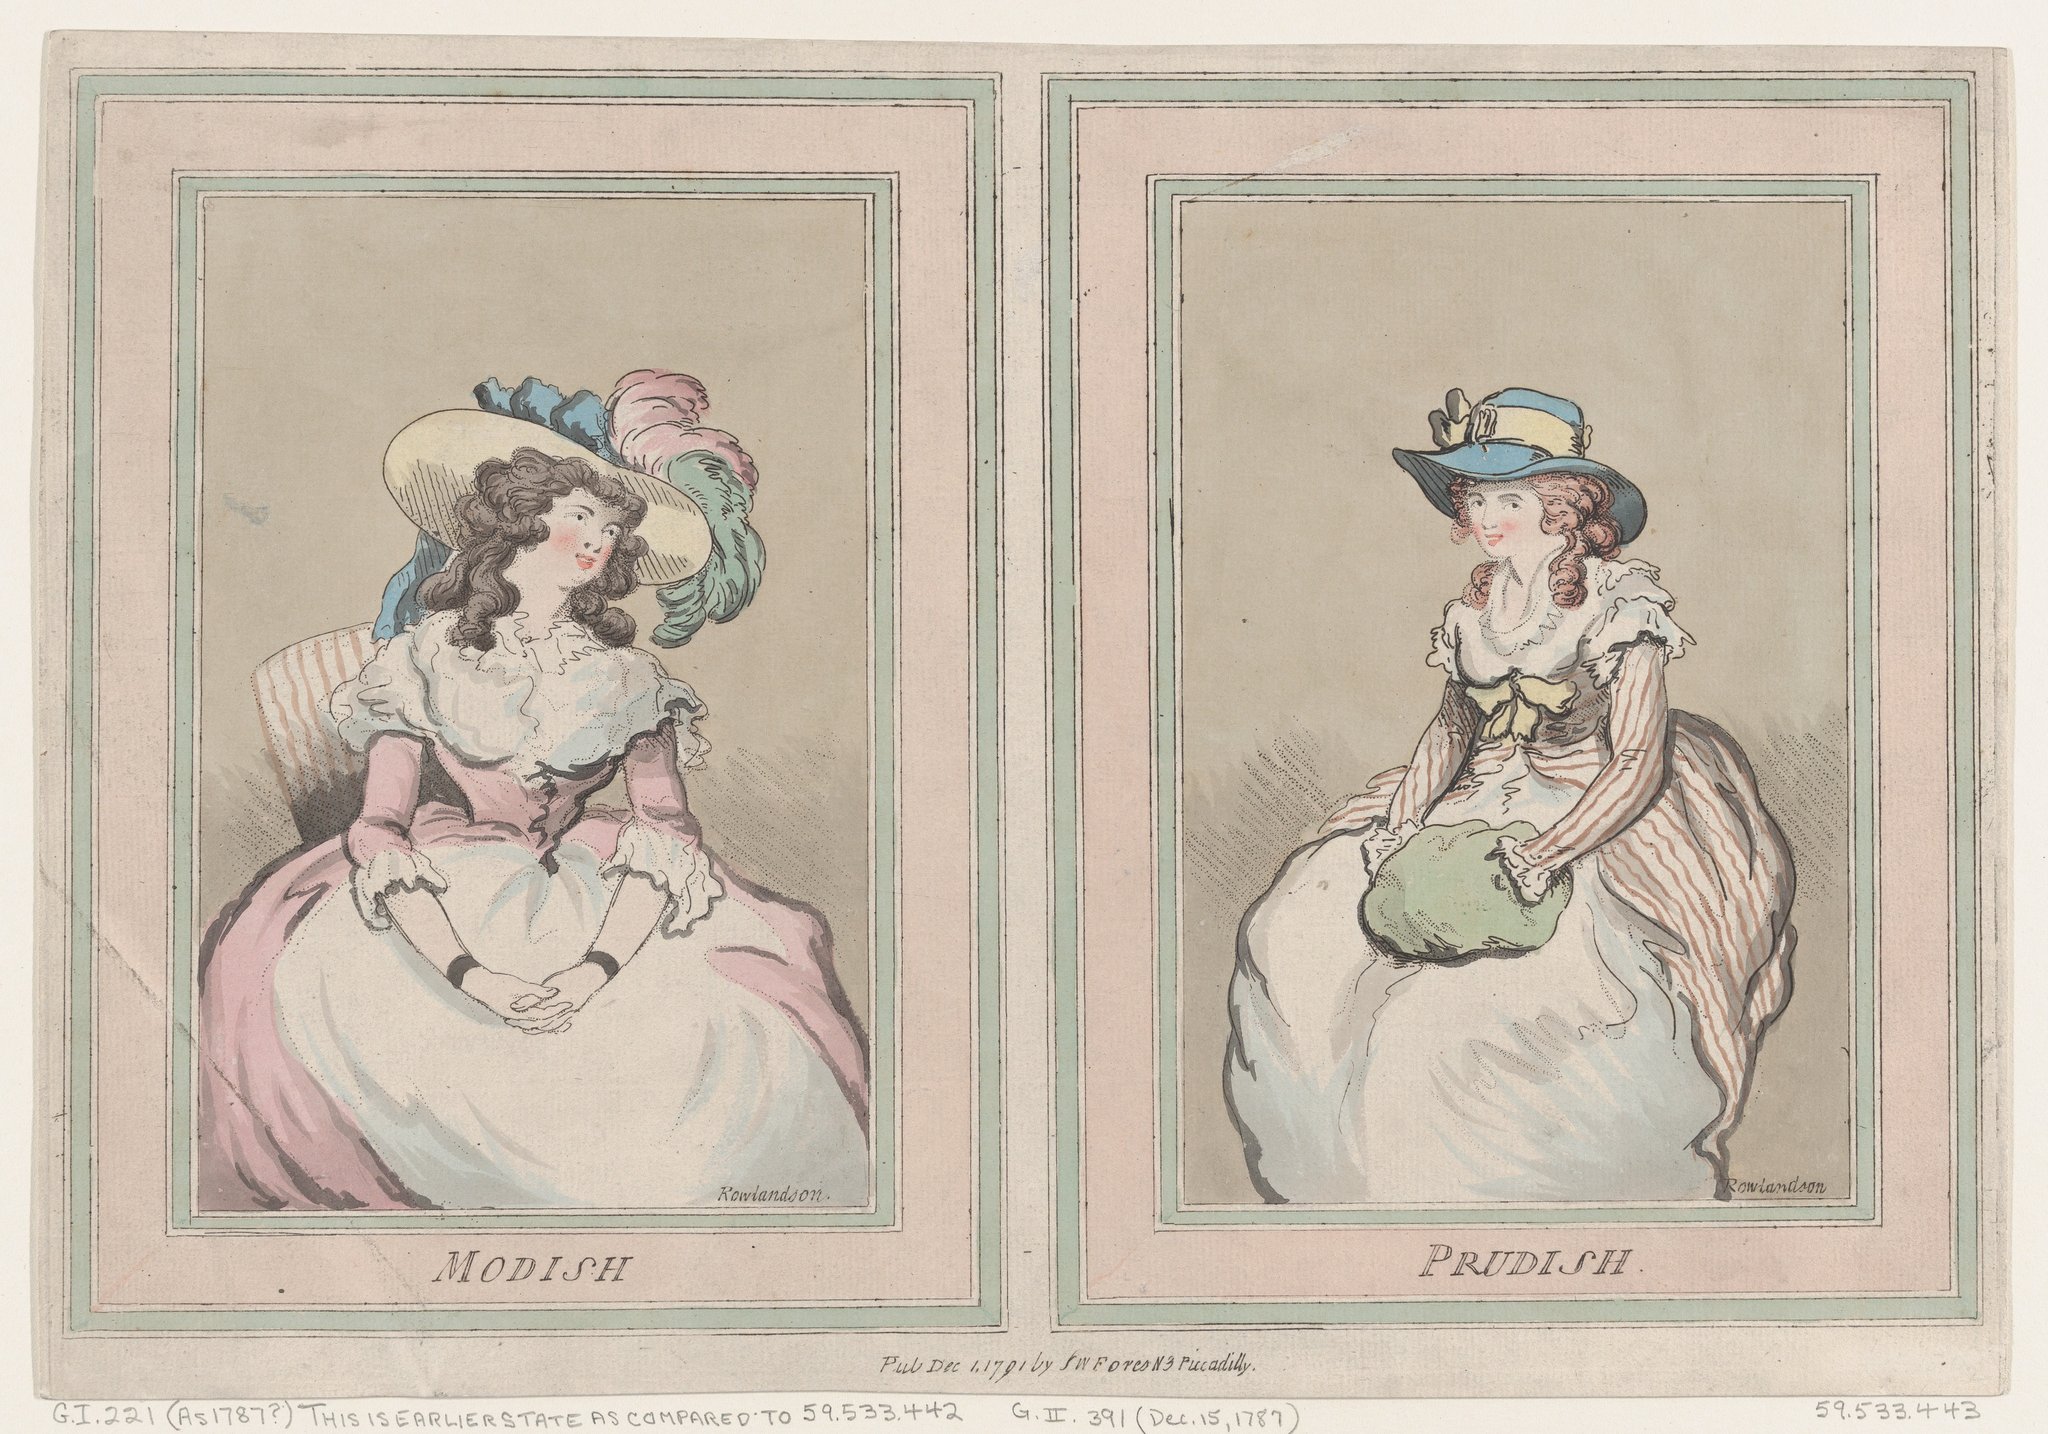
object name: print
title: Modish and Prudish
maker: thomas rowlandson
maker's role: artist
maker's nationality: british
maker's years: 1757-1827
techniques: etching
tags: women